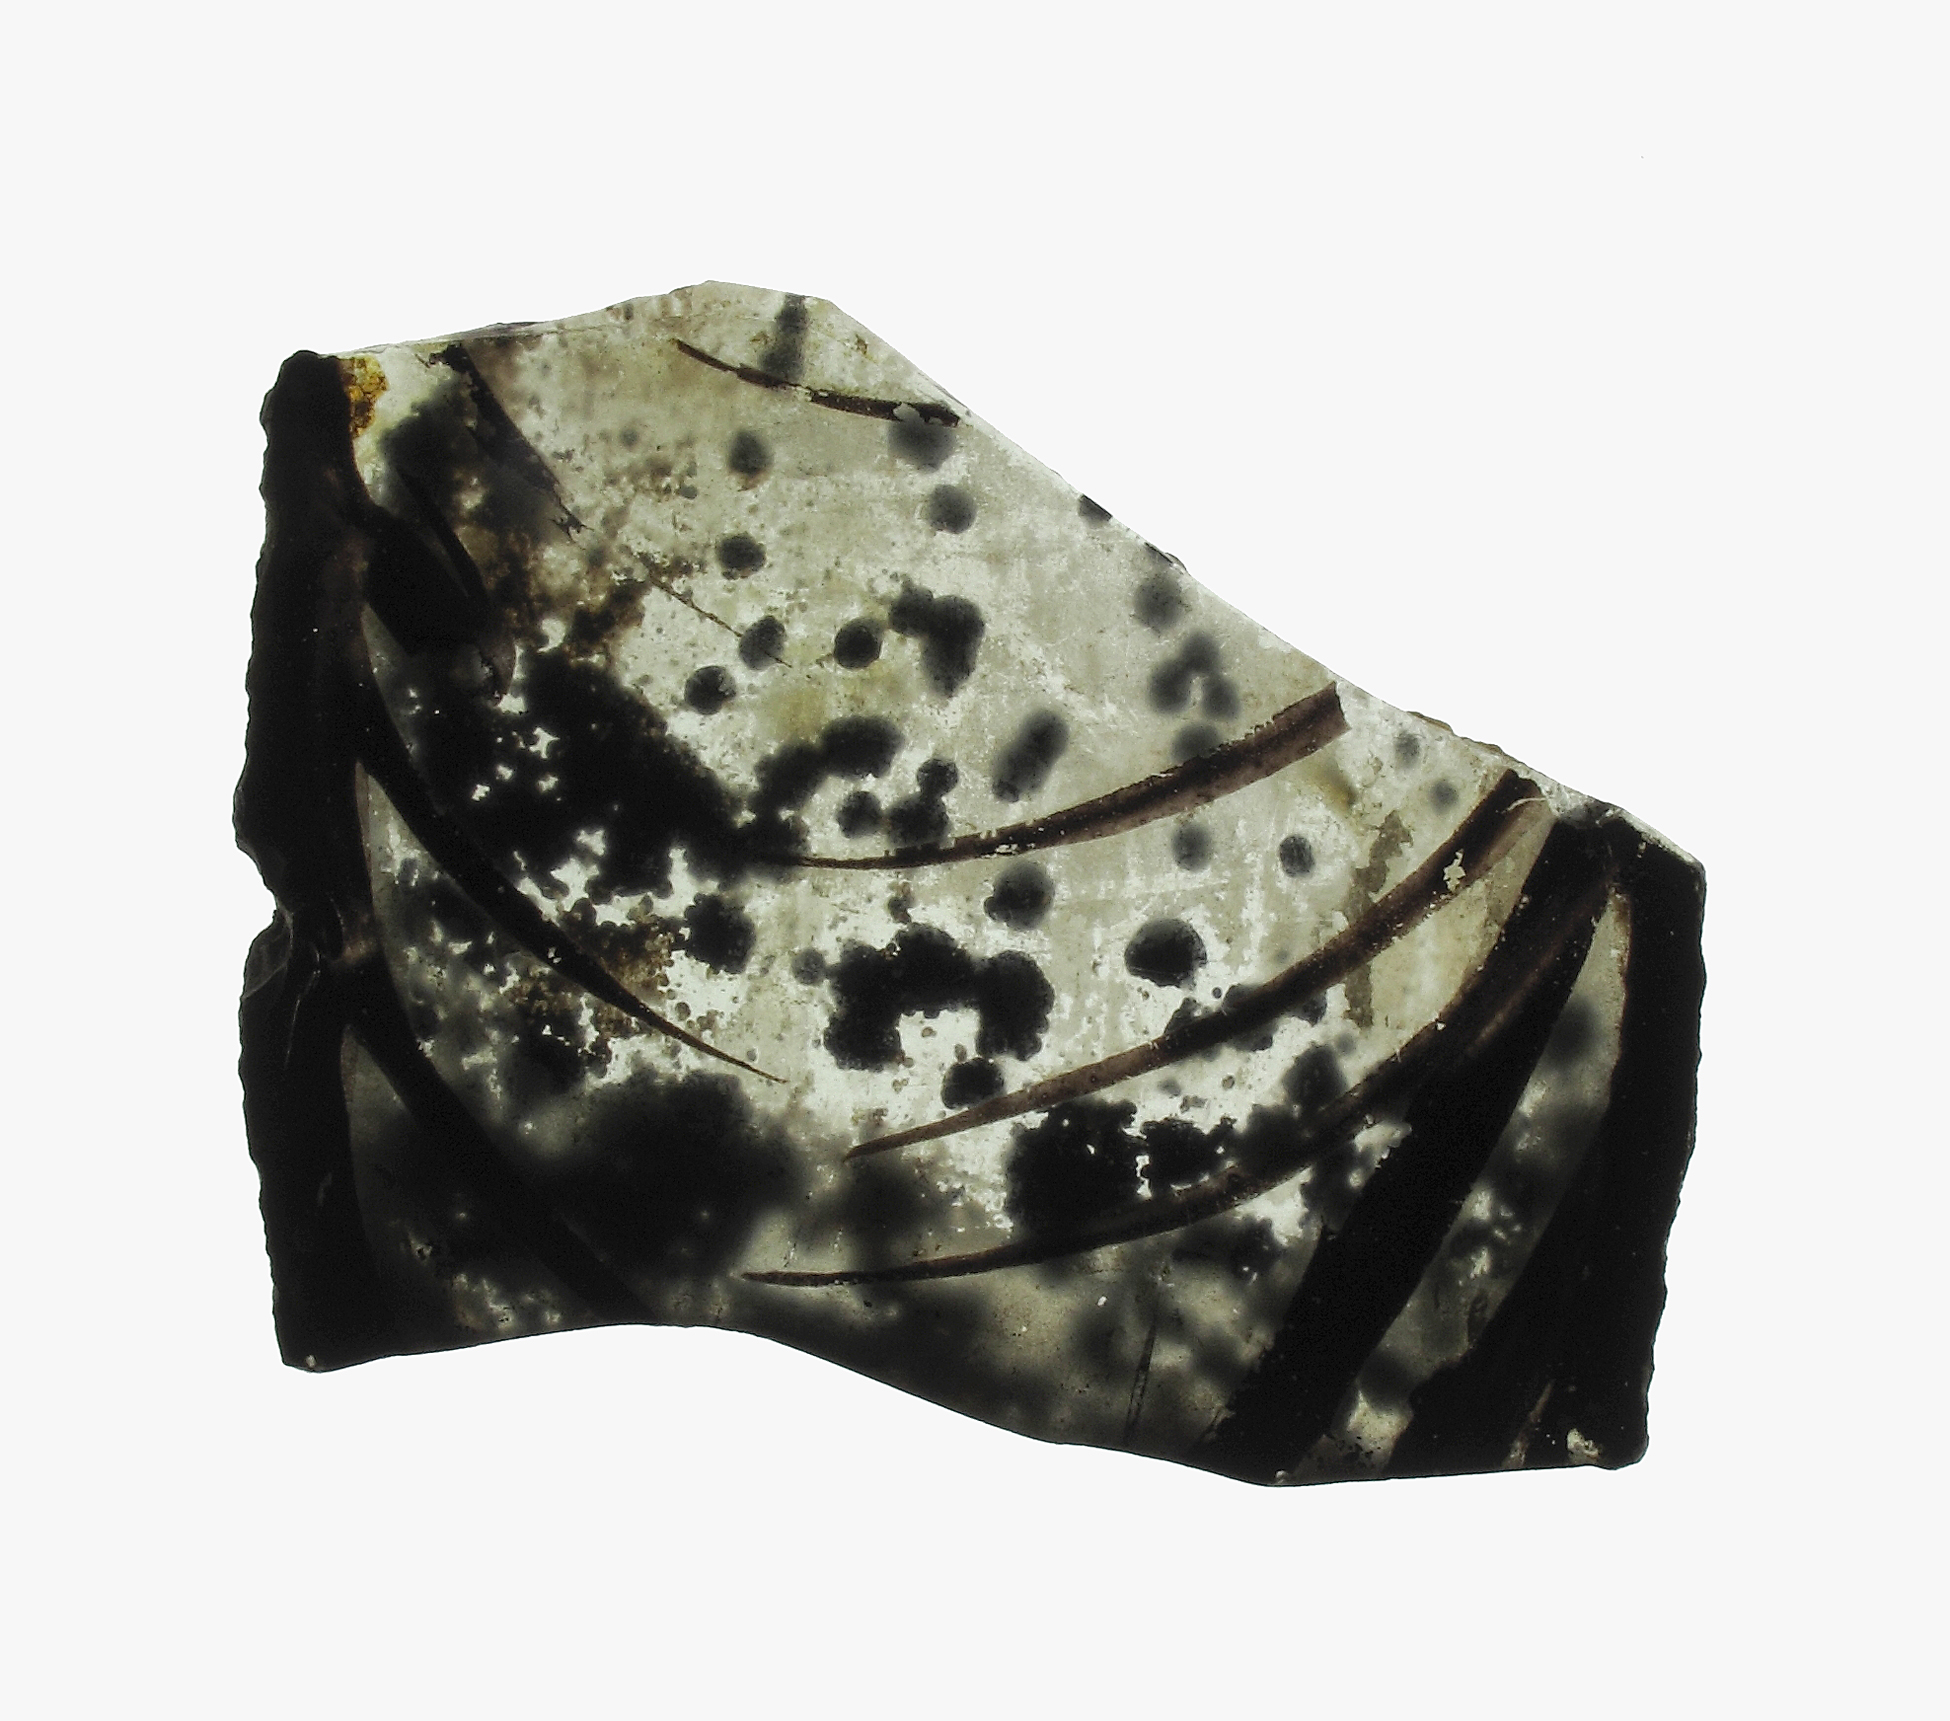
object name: fragment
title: Glass Fragment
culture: european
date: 1301-1500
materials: glass